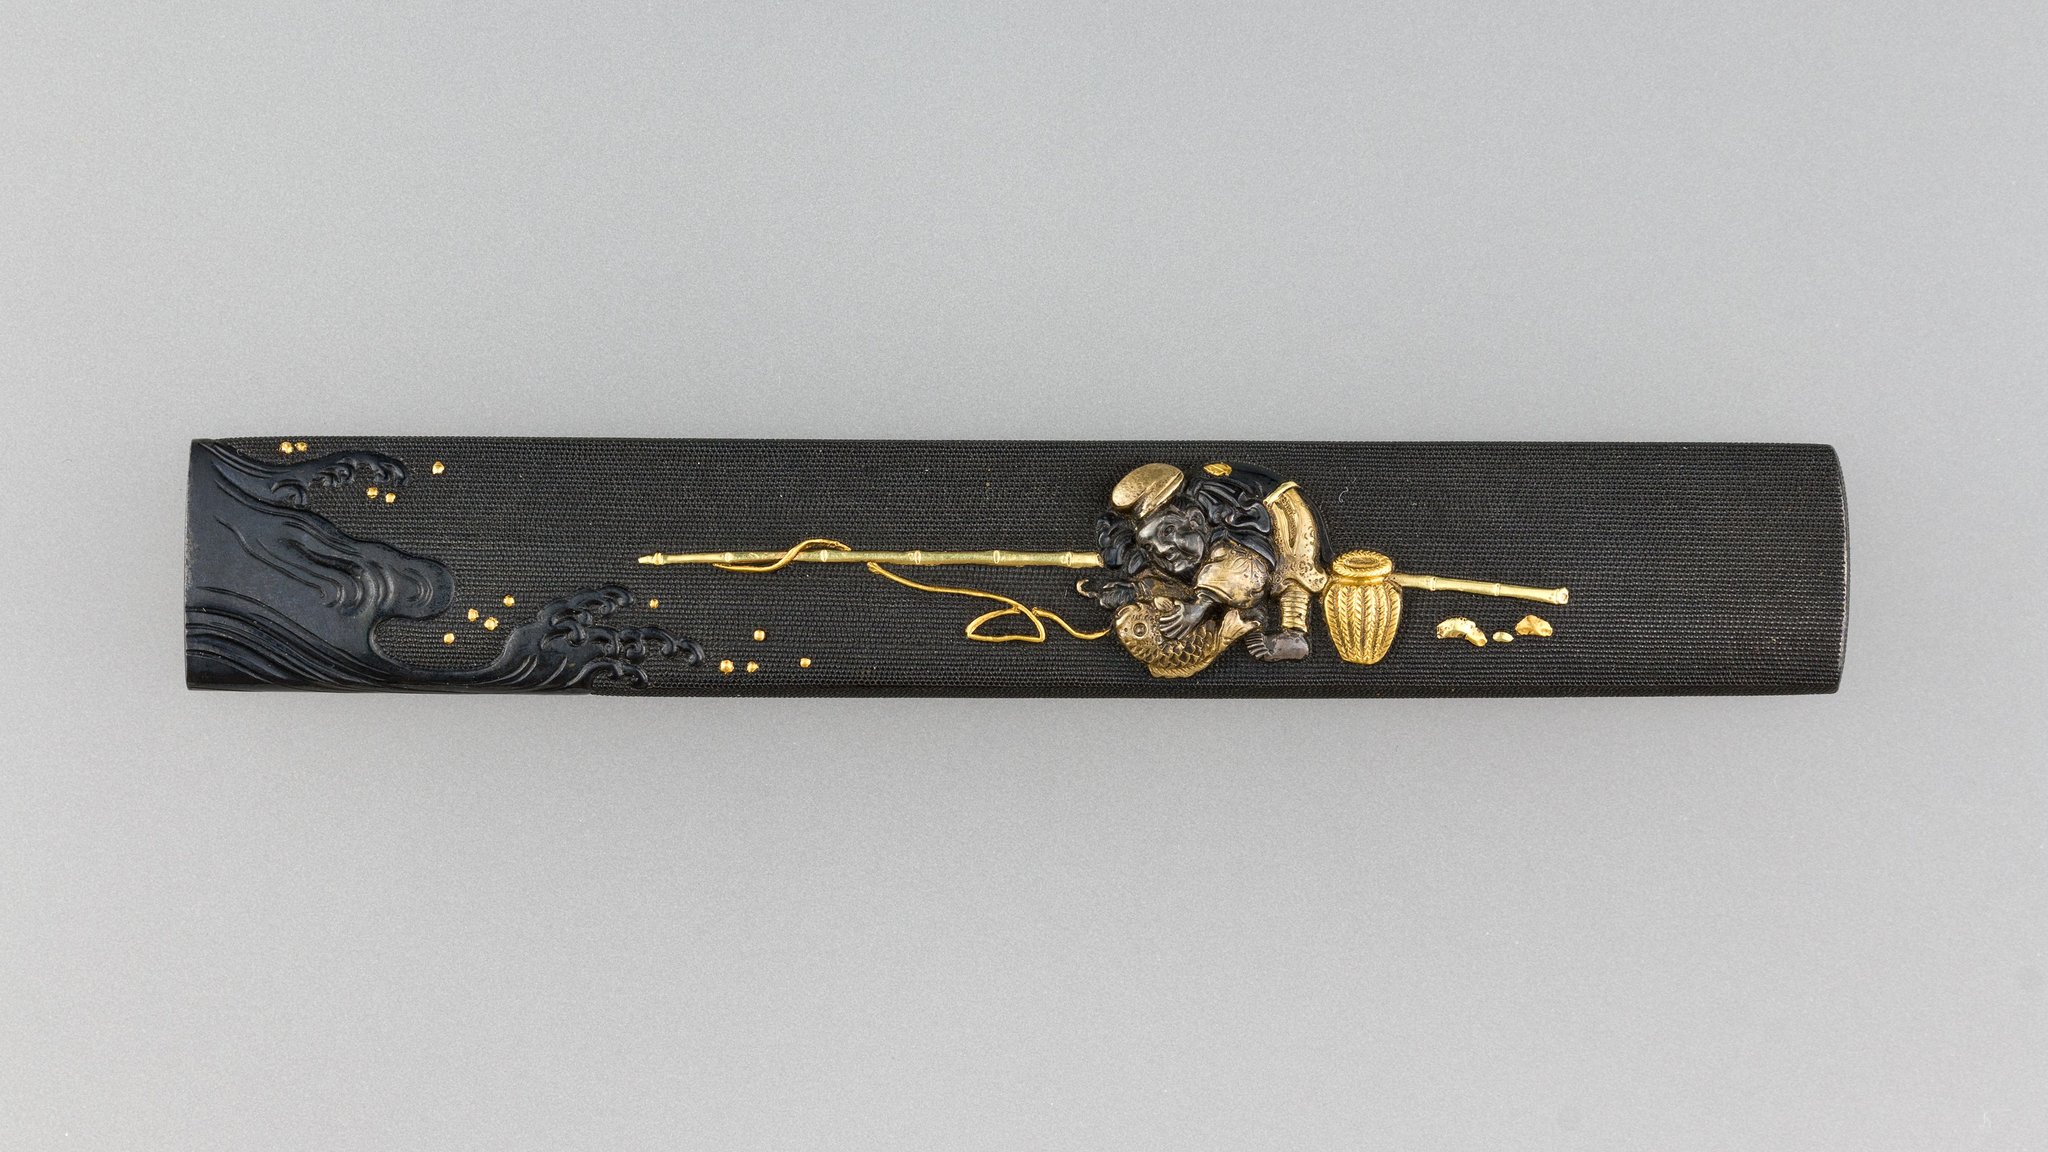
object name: knife handle kozuka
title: Knife Handle (Kozuka)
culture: japanese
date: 1743-1801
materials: gold alloy, silver alloy, gold, silver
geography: japan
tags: men,fishing